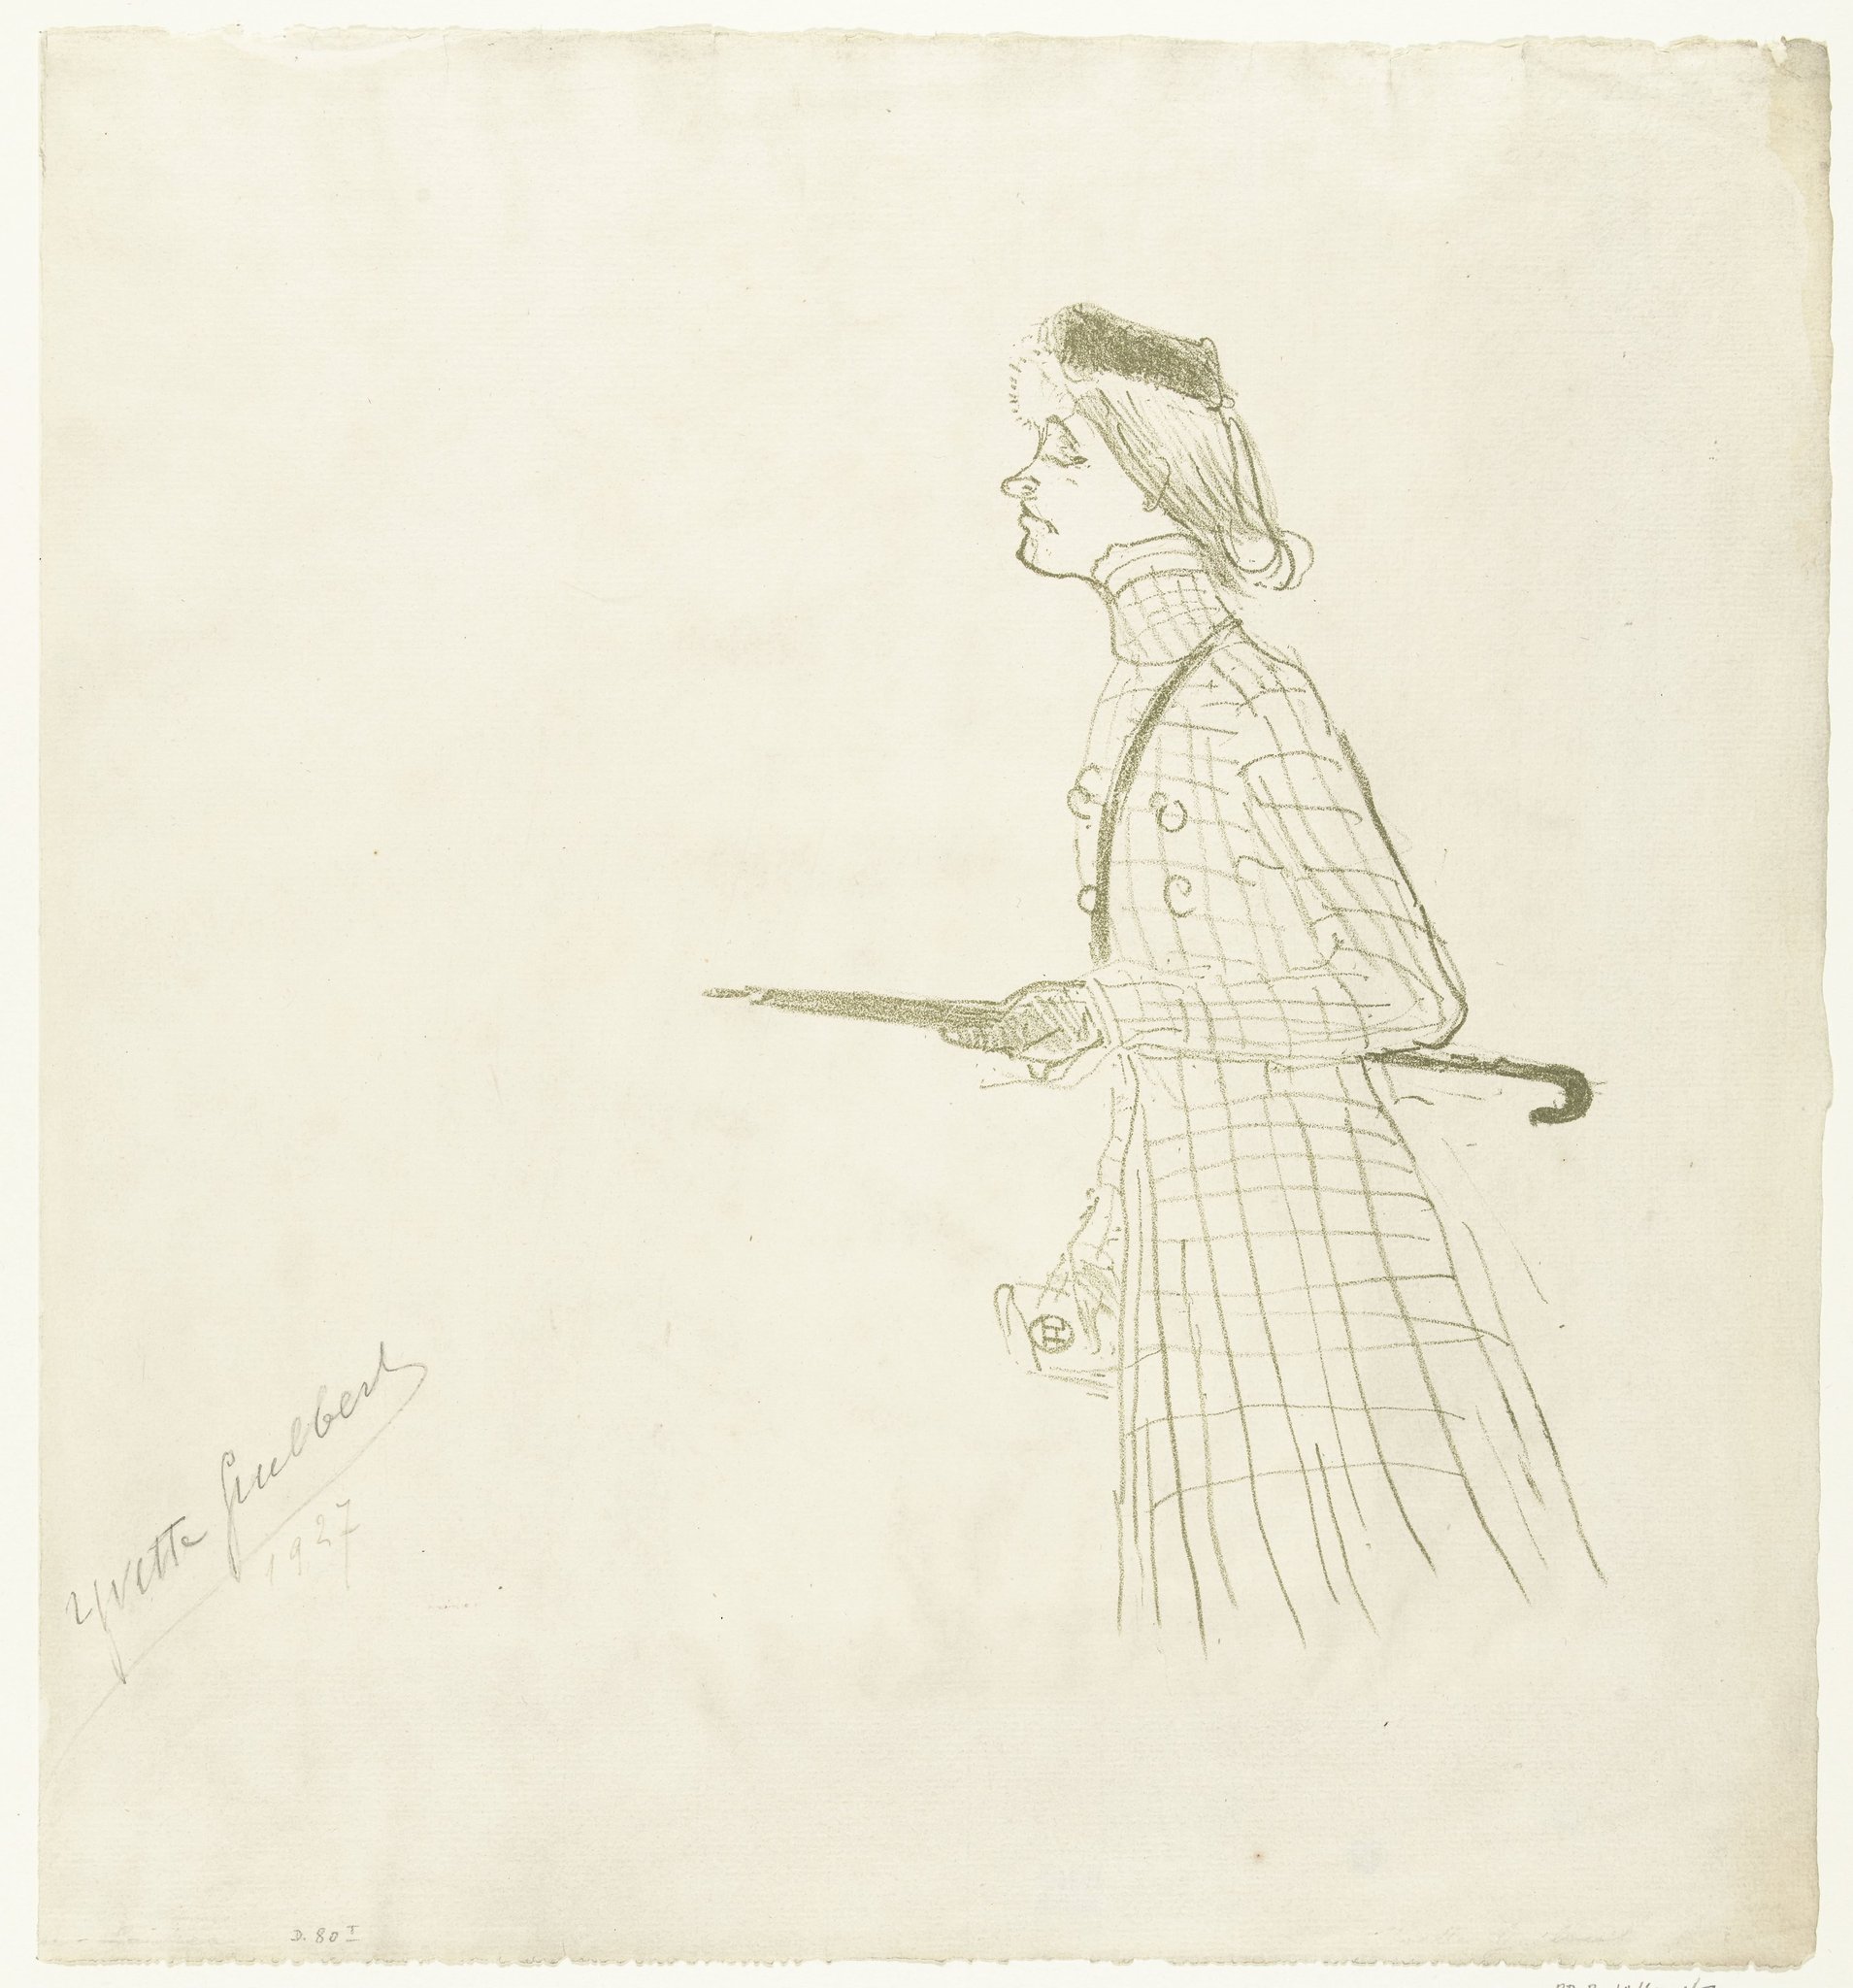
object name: print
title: Portret van actrice Yvette Guilbert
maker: henri de toulouse-lautrec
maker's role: draughtsman, painter, print maker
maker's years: 1864-1901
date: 1894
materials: paper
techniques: printing, lithograph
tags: paris, portrait of actor, actress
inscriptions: collector's mark: Lugt 2233, collector's mark: Lugt 2760, signature and date: ‘Yvette Guilbert 1927’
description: Proefdruk voor prent in het album Yvette Guilbert, Gustave Geffroy (tekst), Édouard Ancourt (drukker), L'Estampe originale (uitgever), eerste prent. Er zijn tien proefdrukken bekend uitgevoerd in verschillende tinten groen (Wittrock 1985, p. 200).